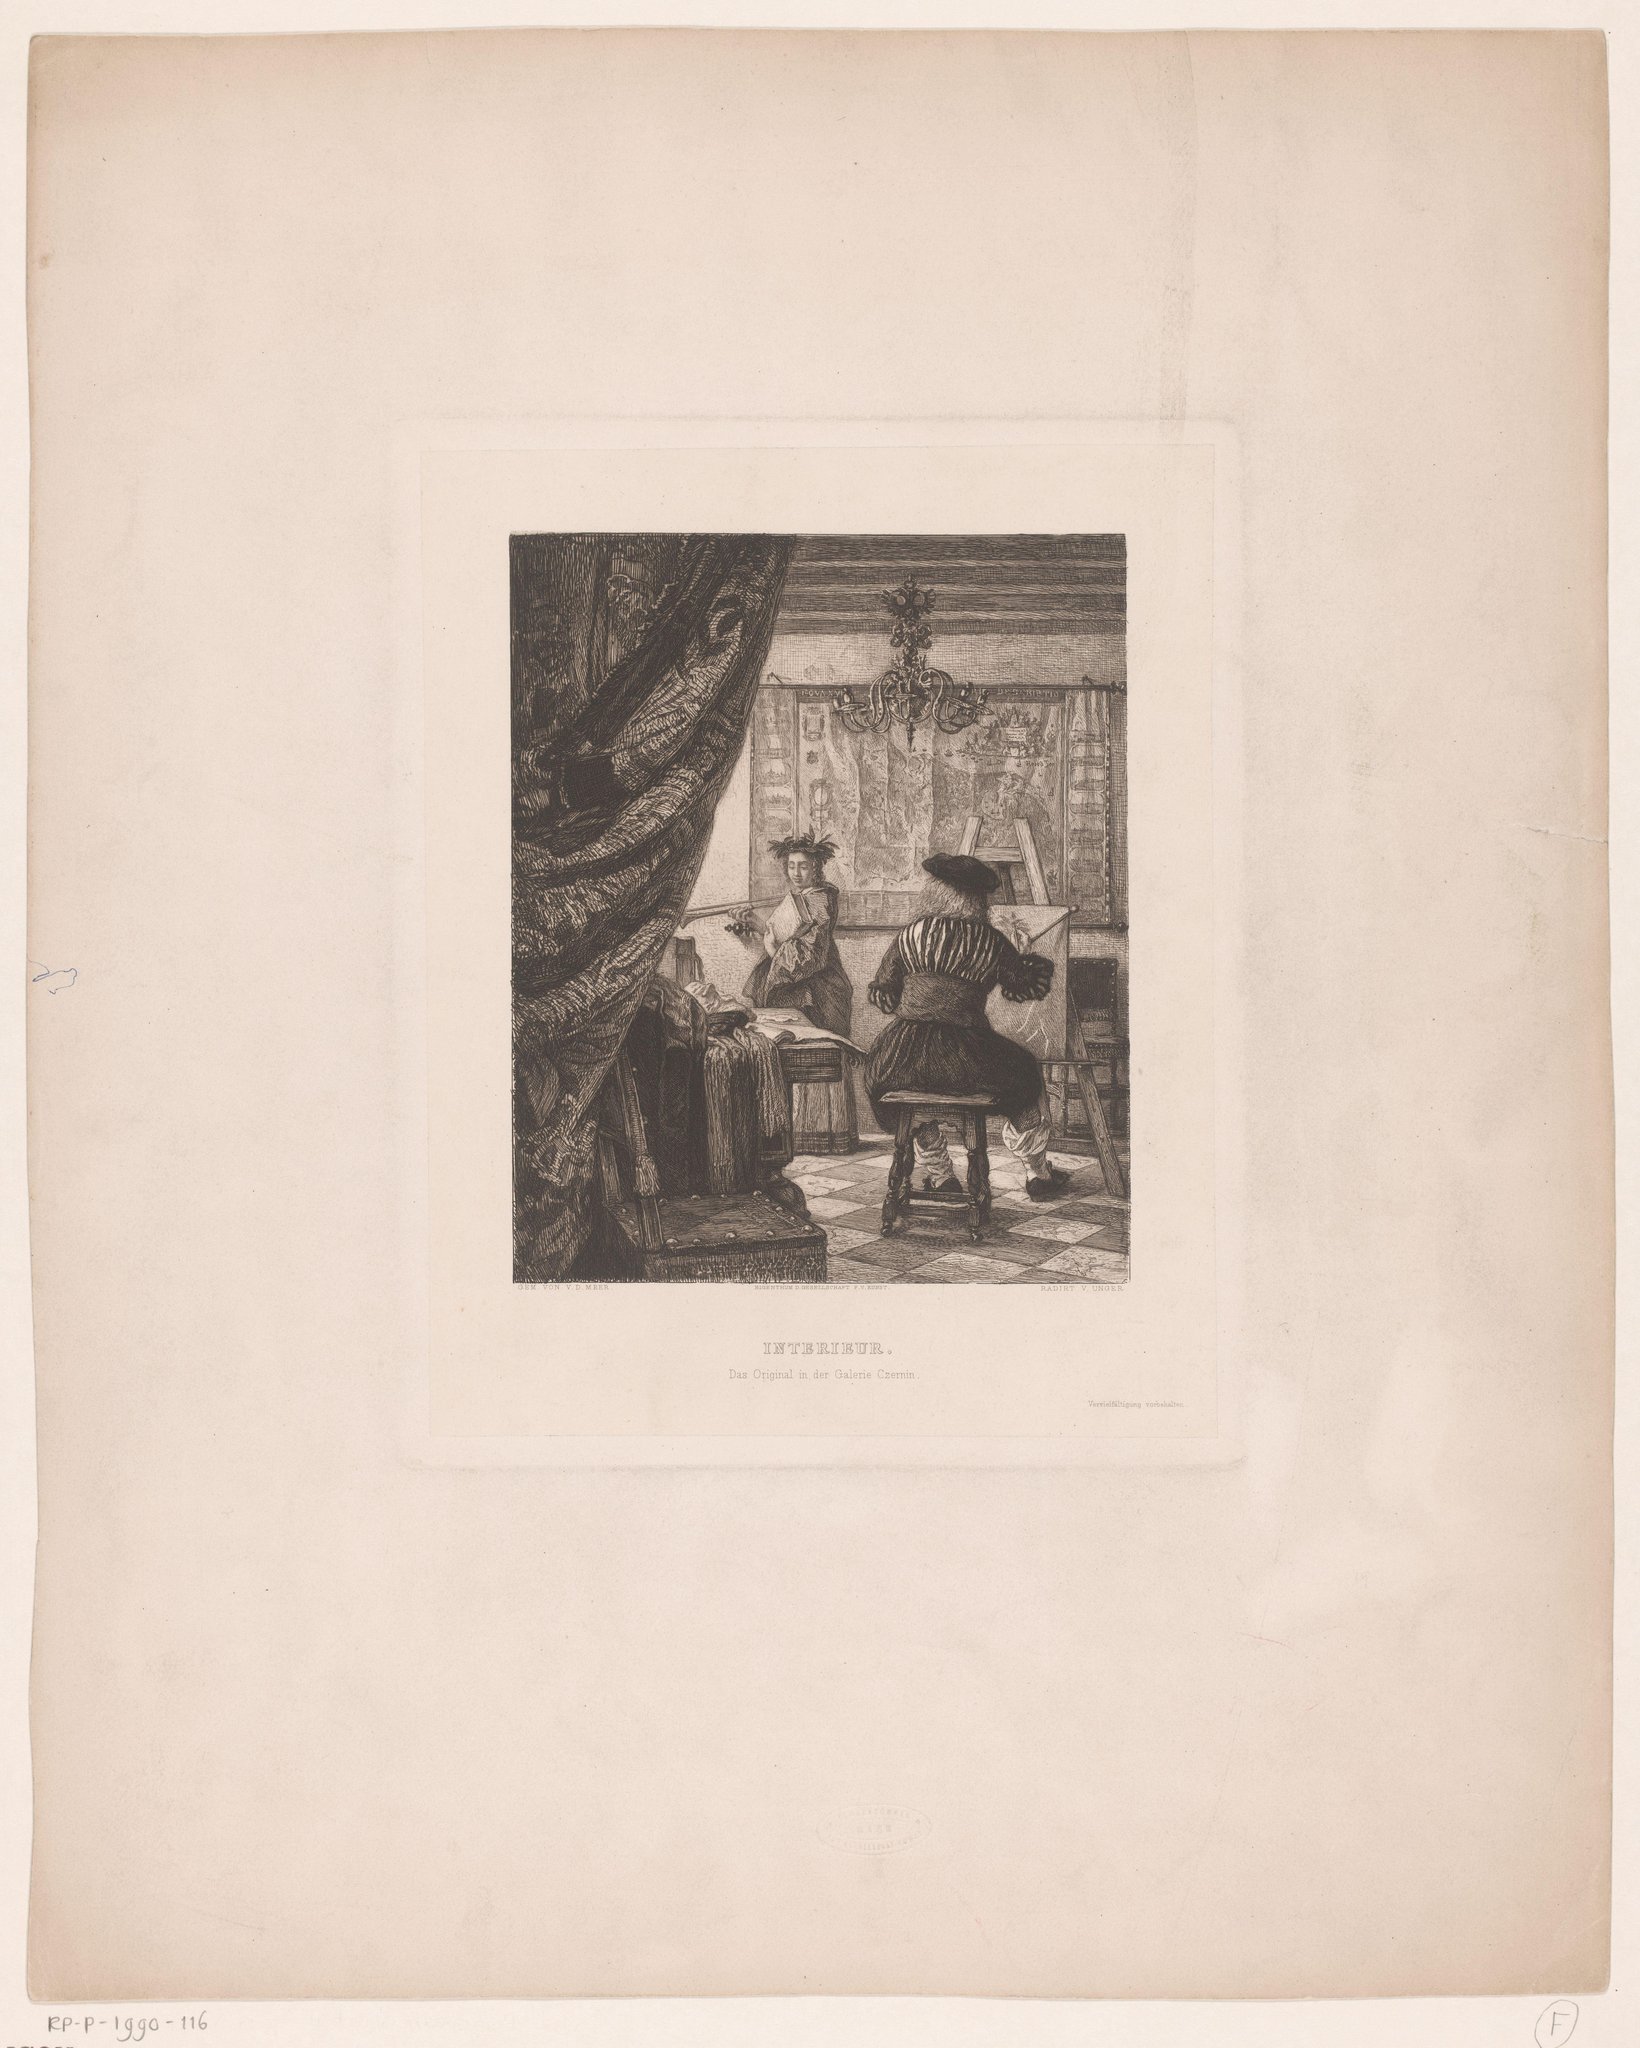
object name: print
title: Schilderkunst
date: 1847-1932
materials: paper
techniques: etching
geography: germany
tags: horn, trumpet, cornet, trombone, tuba, maps, atlases, model, sitter ~ painting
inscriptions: collector's mark: Lugt 2228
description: Prent naar het schilderij door Johannes Vermeer in het Kunsthistorisches Museum te Wenen.